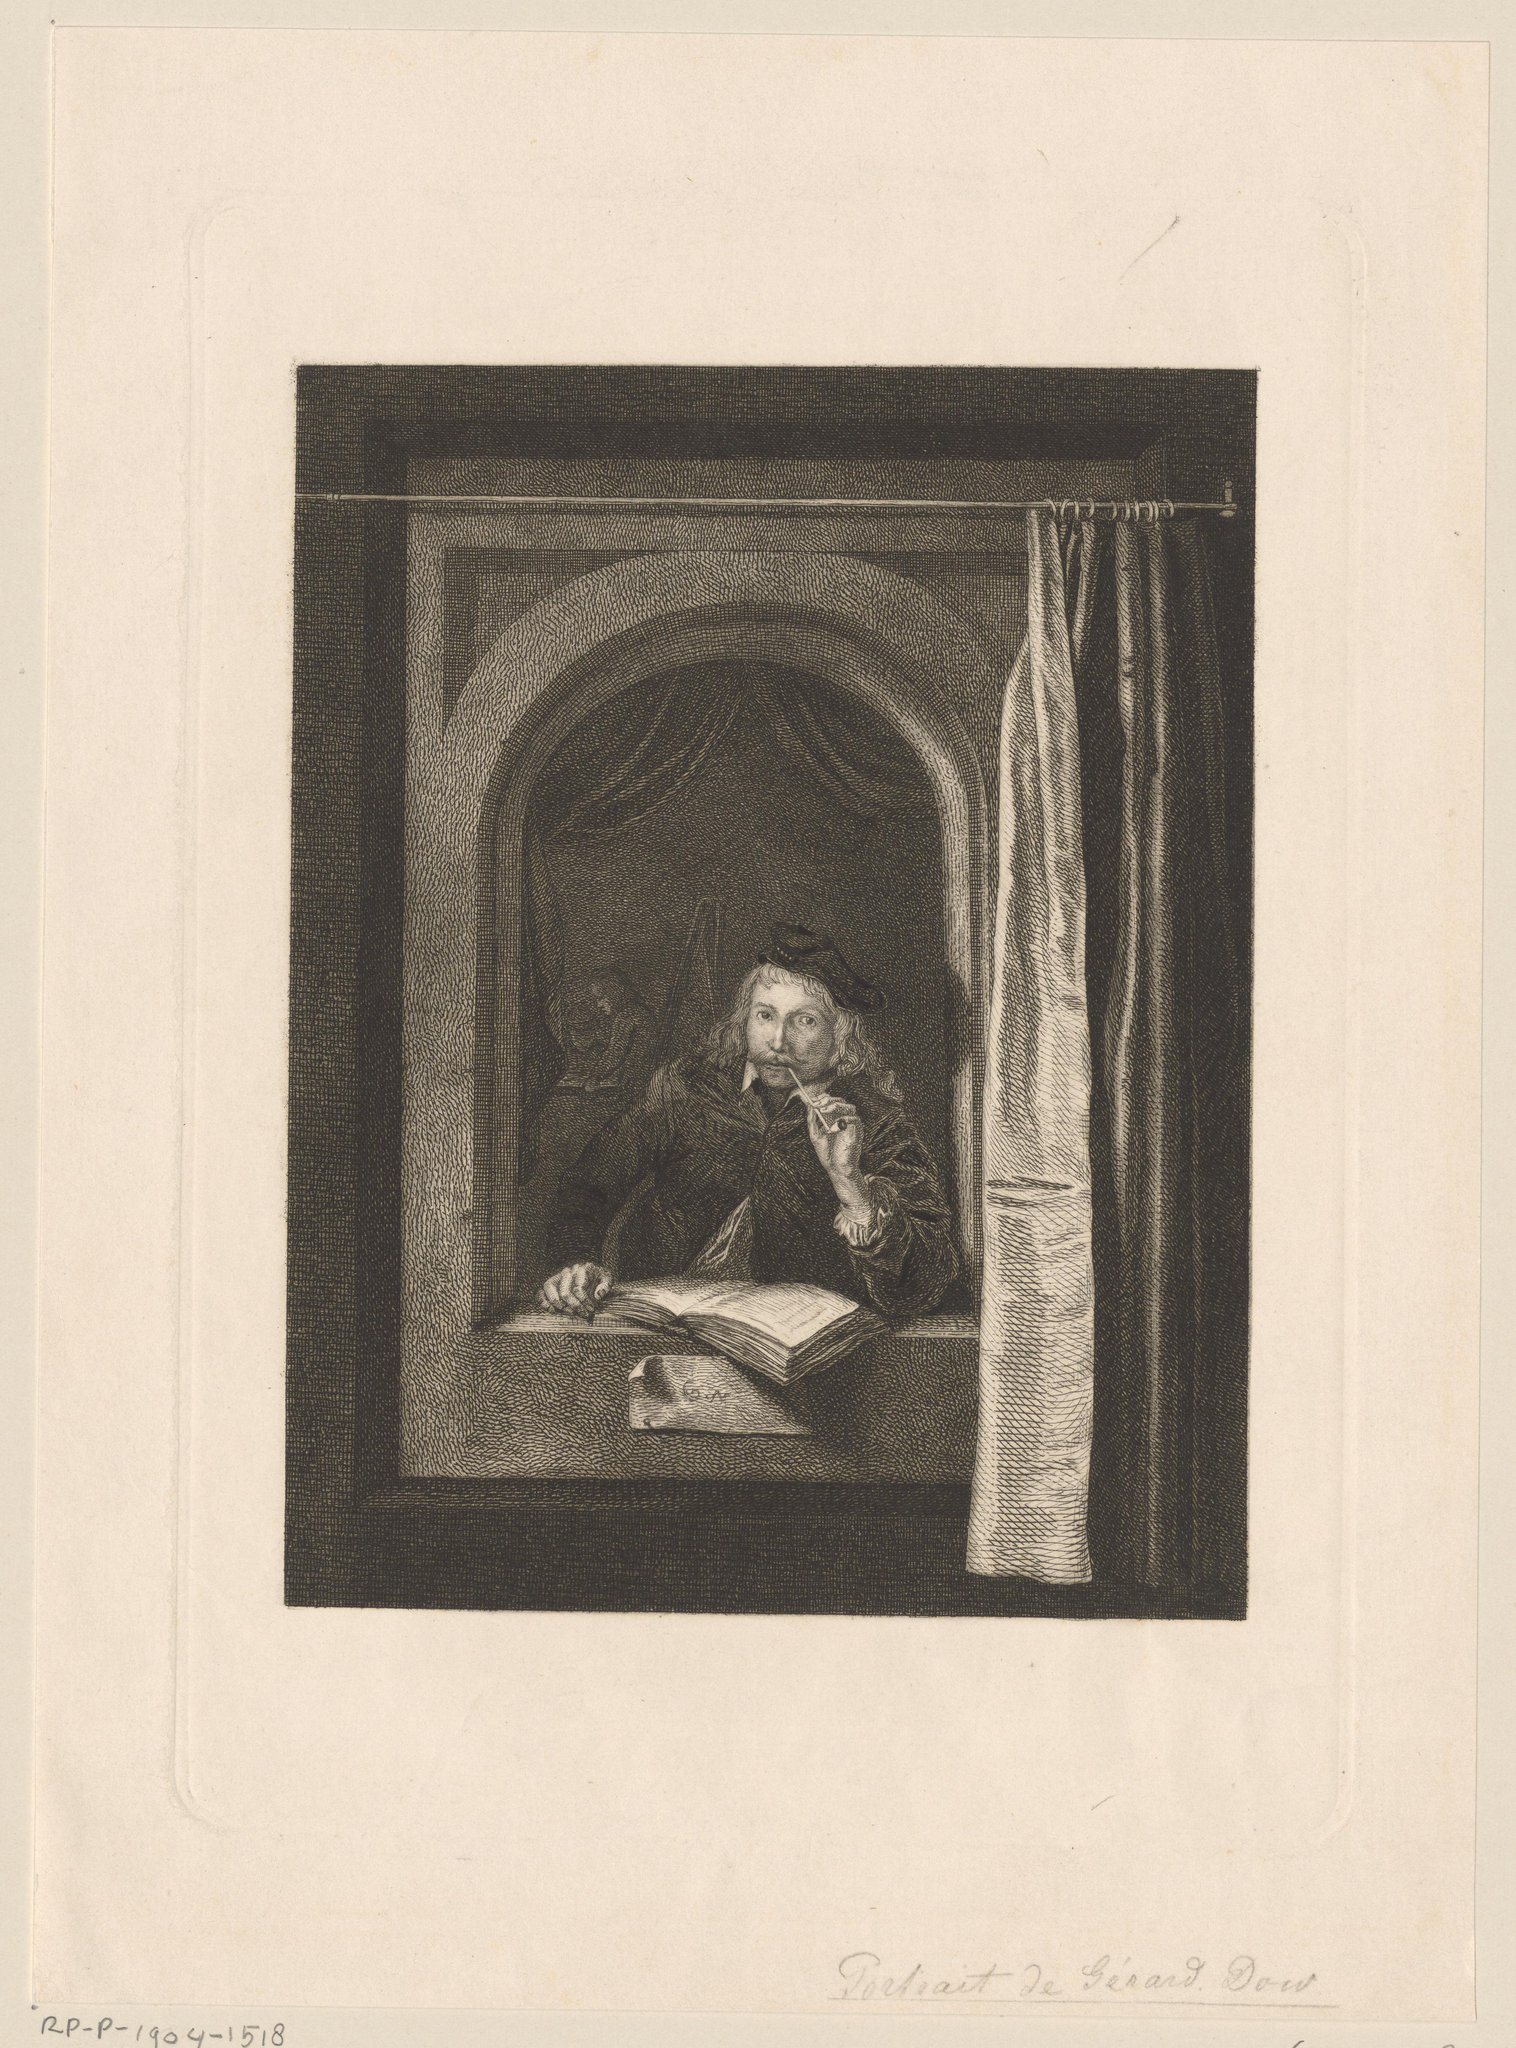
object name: print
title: Pijprokende man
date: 1850-1904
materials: paper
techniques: etching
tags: curtains, pipe ~ tobacco, human figure at (open) window, seen from outside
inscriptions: collector's mark: Lugt 2228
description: Leunend op een raamkozijn met een pijp in zijn mond. Voor hem ligt een opengeslagen boek.